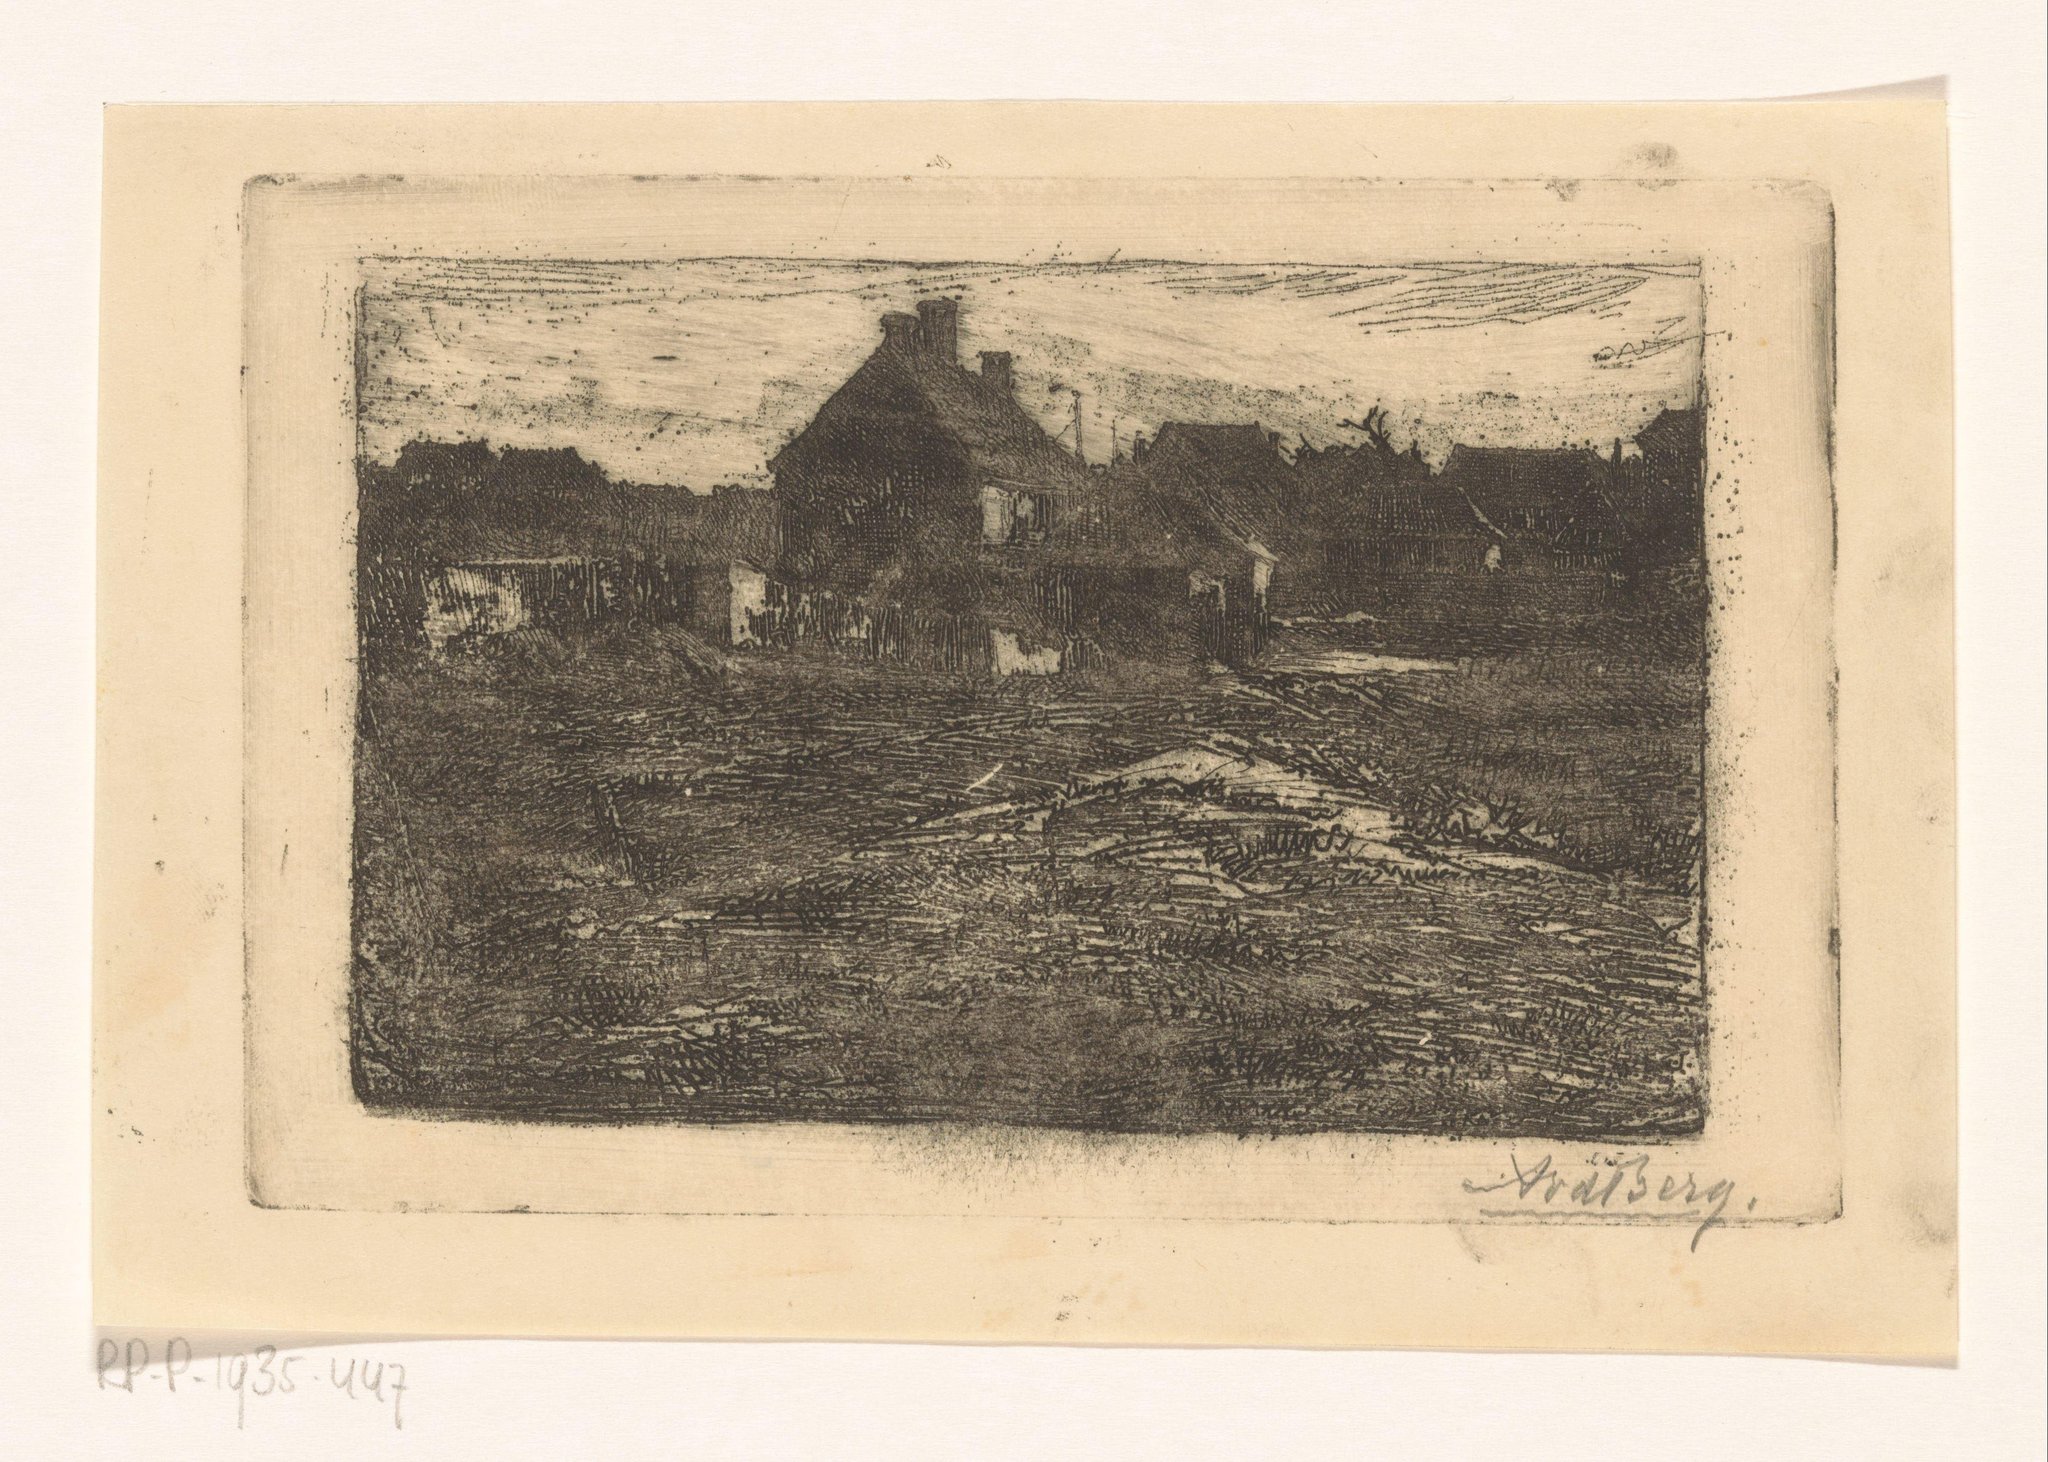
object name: print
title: Dorpsgezicht bij avond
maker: andries van den berg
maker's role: draughtsman, painter, print maker, publisher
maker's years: 1852-1944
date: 1862-1935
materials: paper, ink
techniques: drypoint, etching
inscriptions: collector's mark: Lugt 2228, collector's mark: Lugt 2760, signature: ‘AvdBerg.’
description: Dorpsgezicht in silhouet, schetsmatig weergegeven.